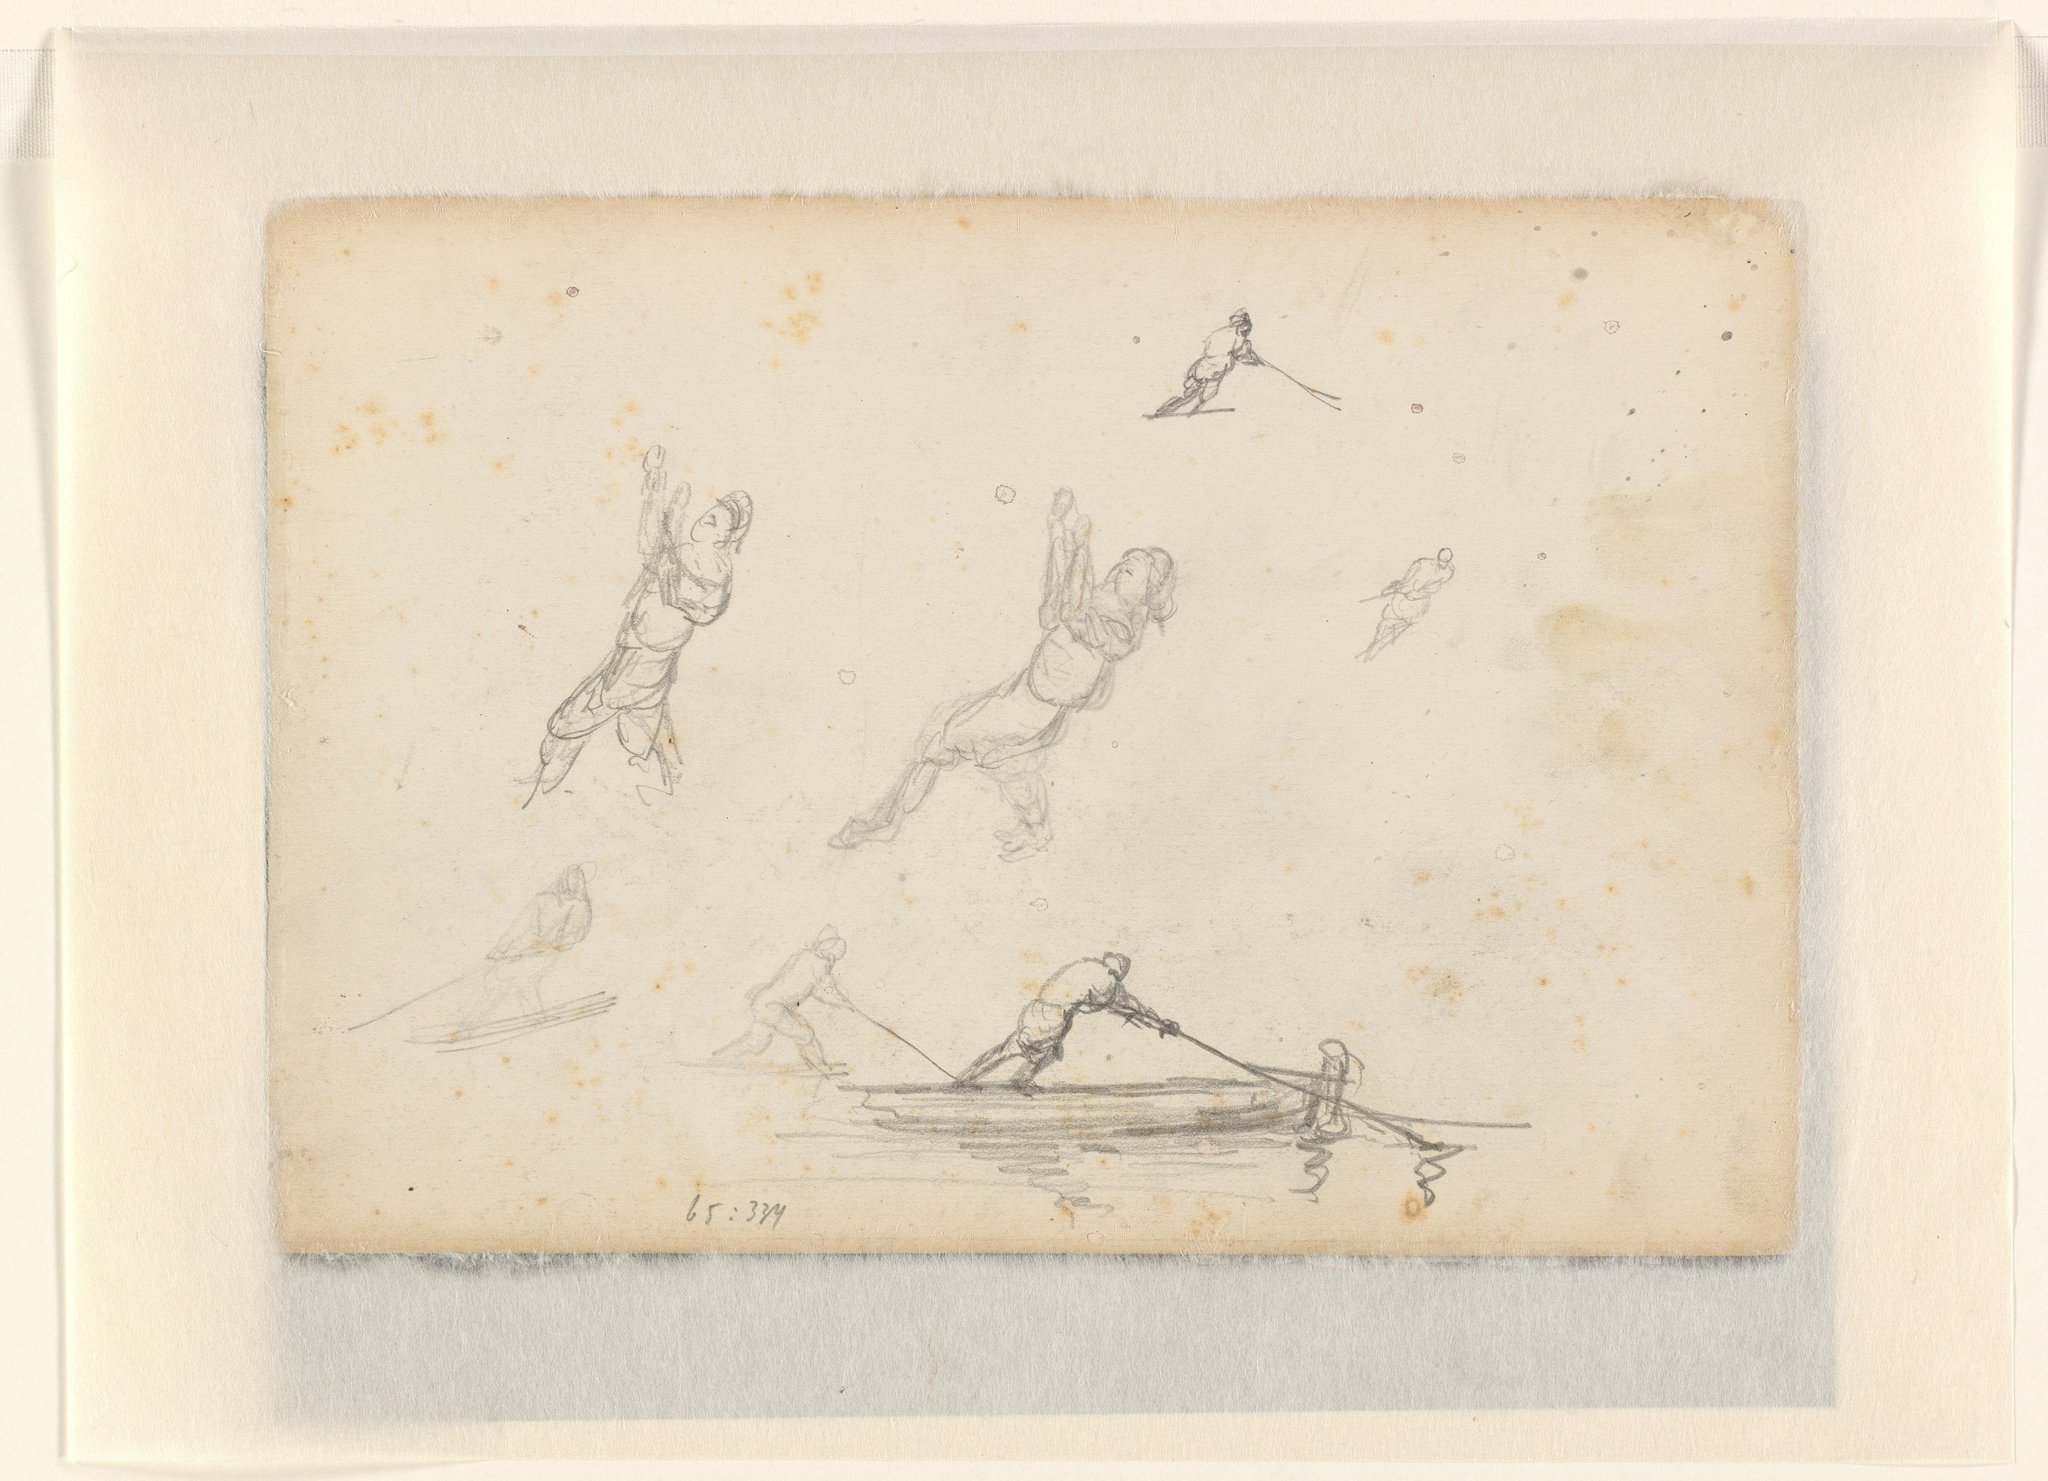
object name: drawing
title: Studieblad met figuren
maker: johannes huygens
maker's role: draughtsman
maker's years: 1833-1911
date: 1843-1911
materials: paper, pencil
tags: drawing, pulling something, arm raised upward - aa - both arms or hands